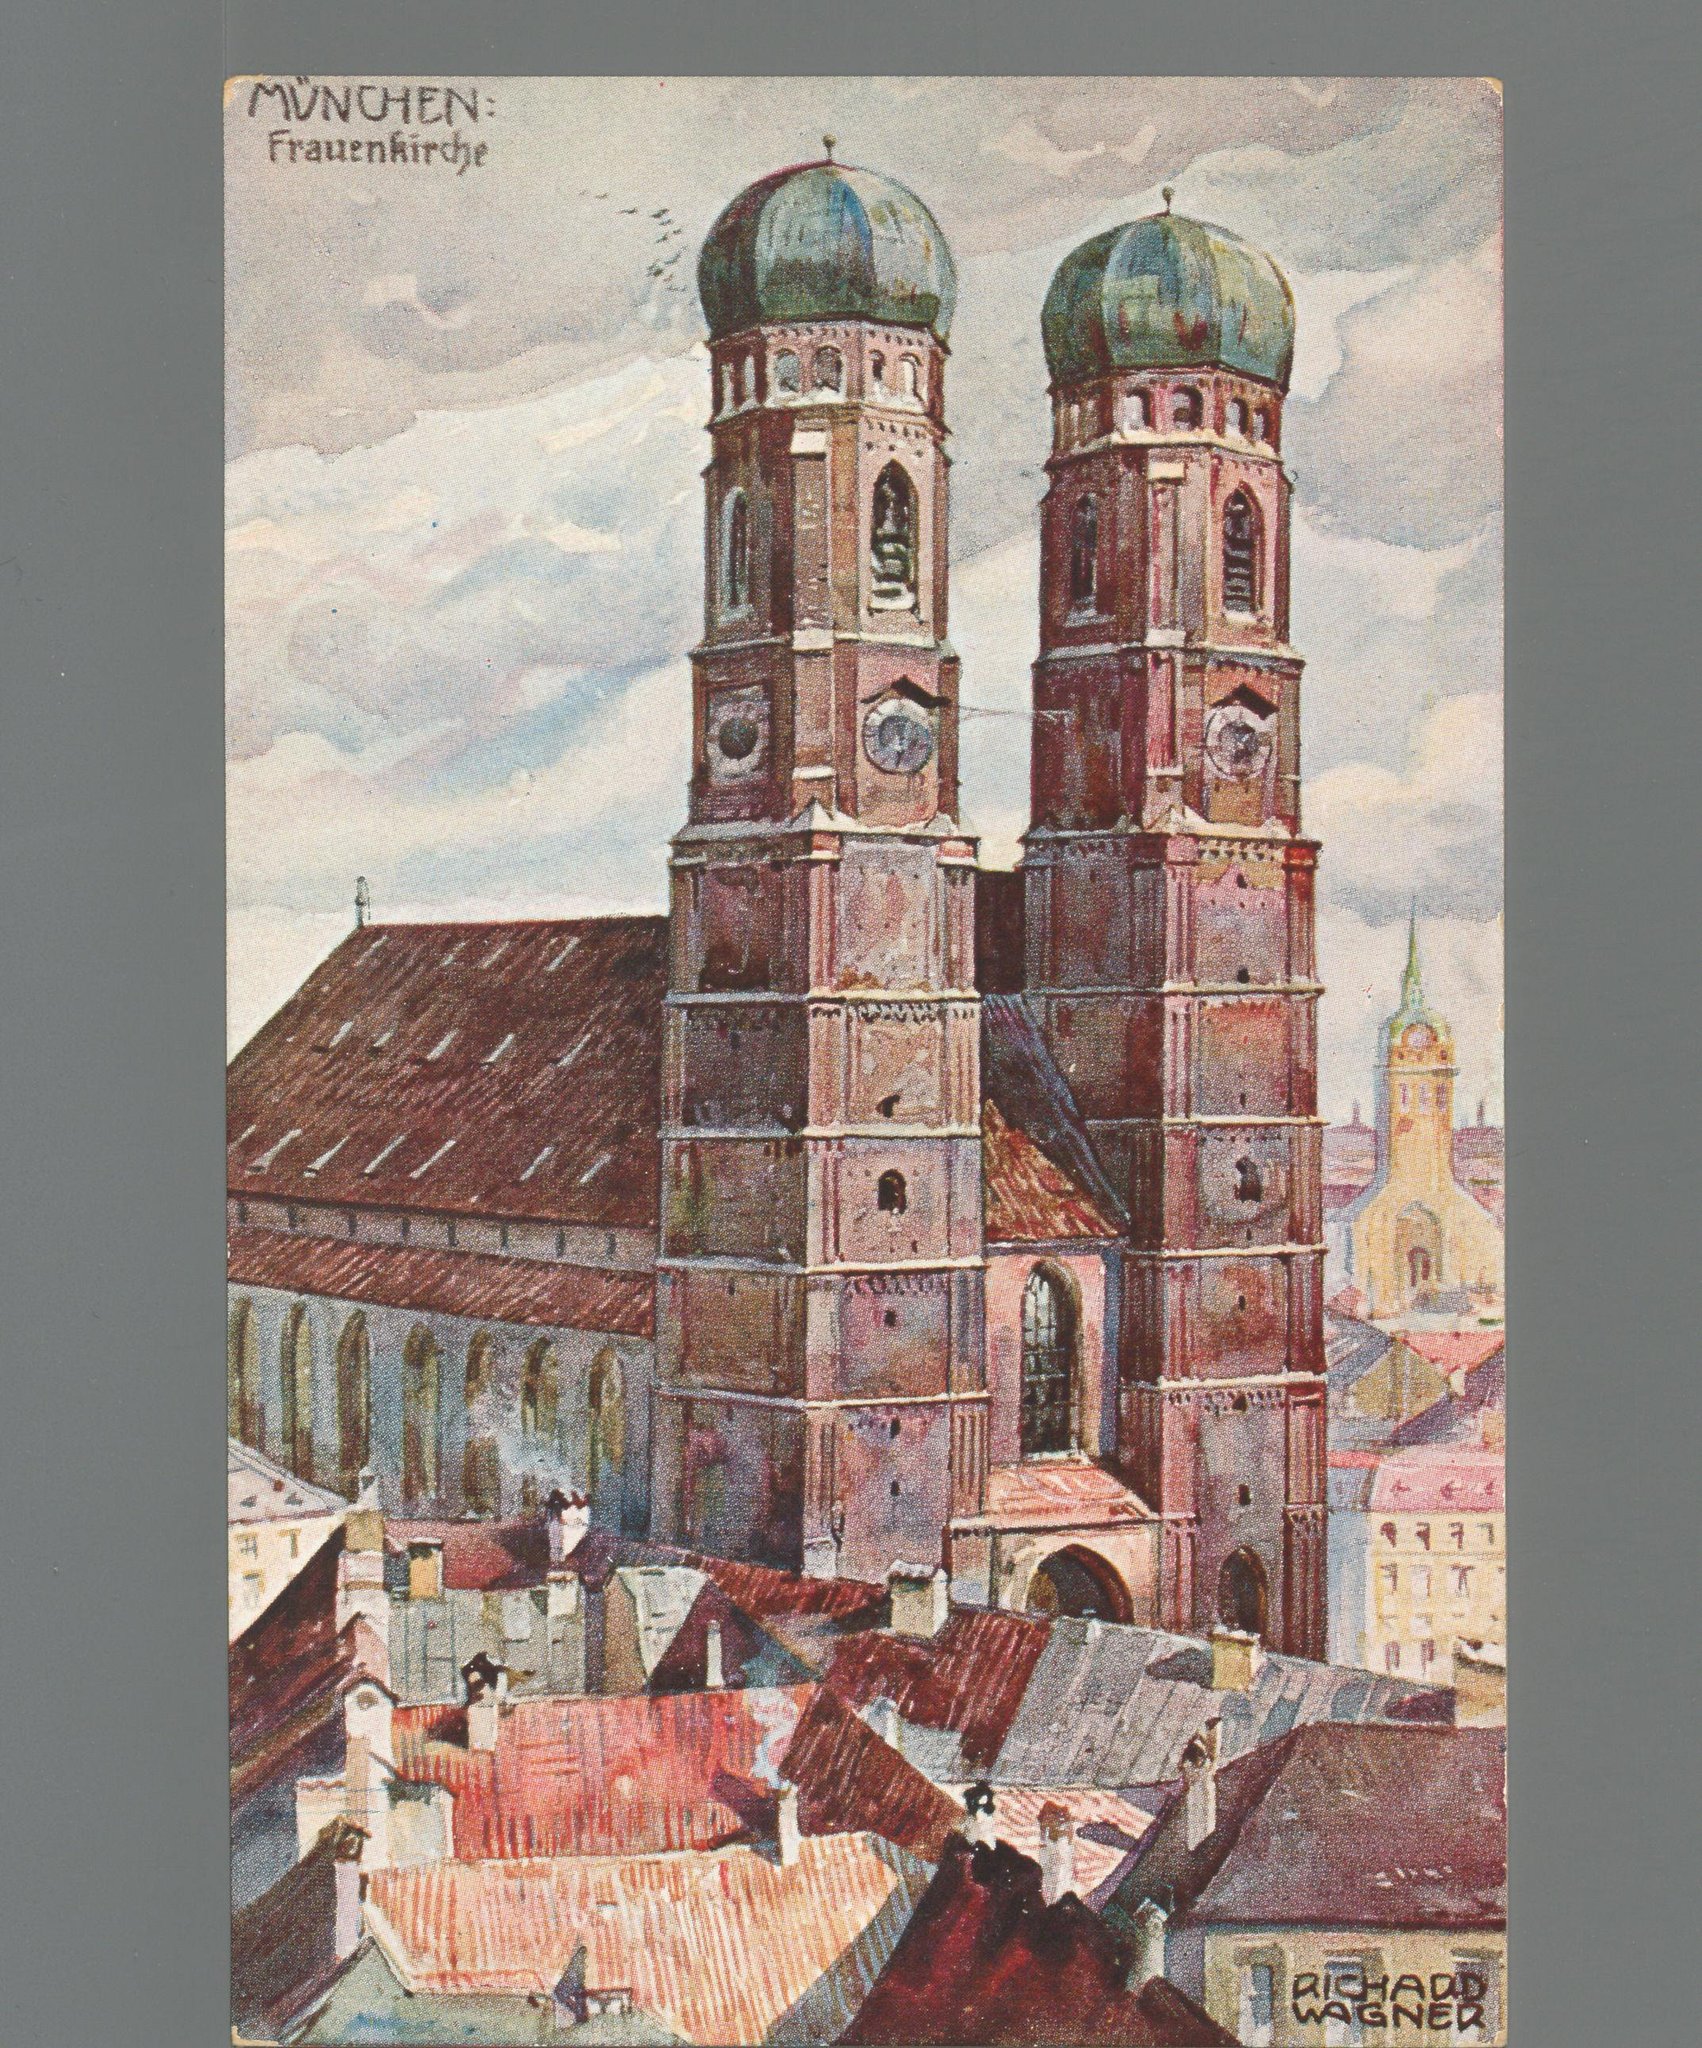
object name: ansichtkaart, prentbriefkaart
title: München: Frauenkirche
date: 1905-1930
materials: cardboard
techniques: color autotype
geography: munich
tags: church (exterior)